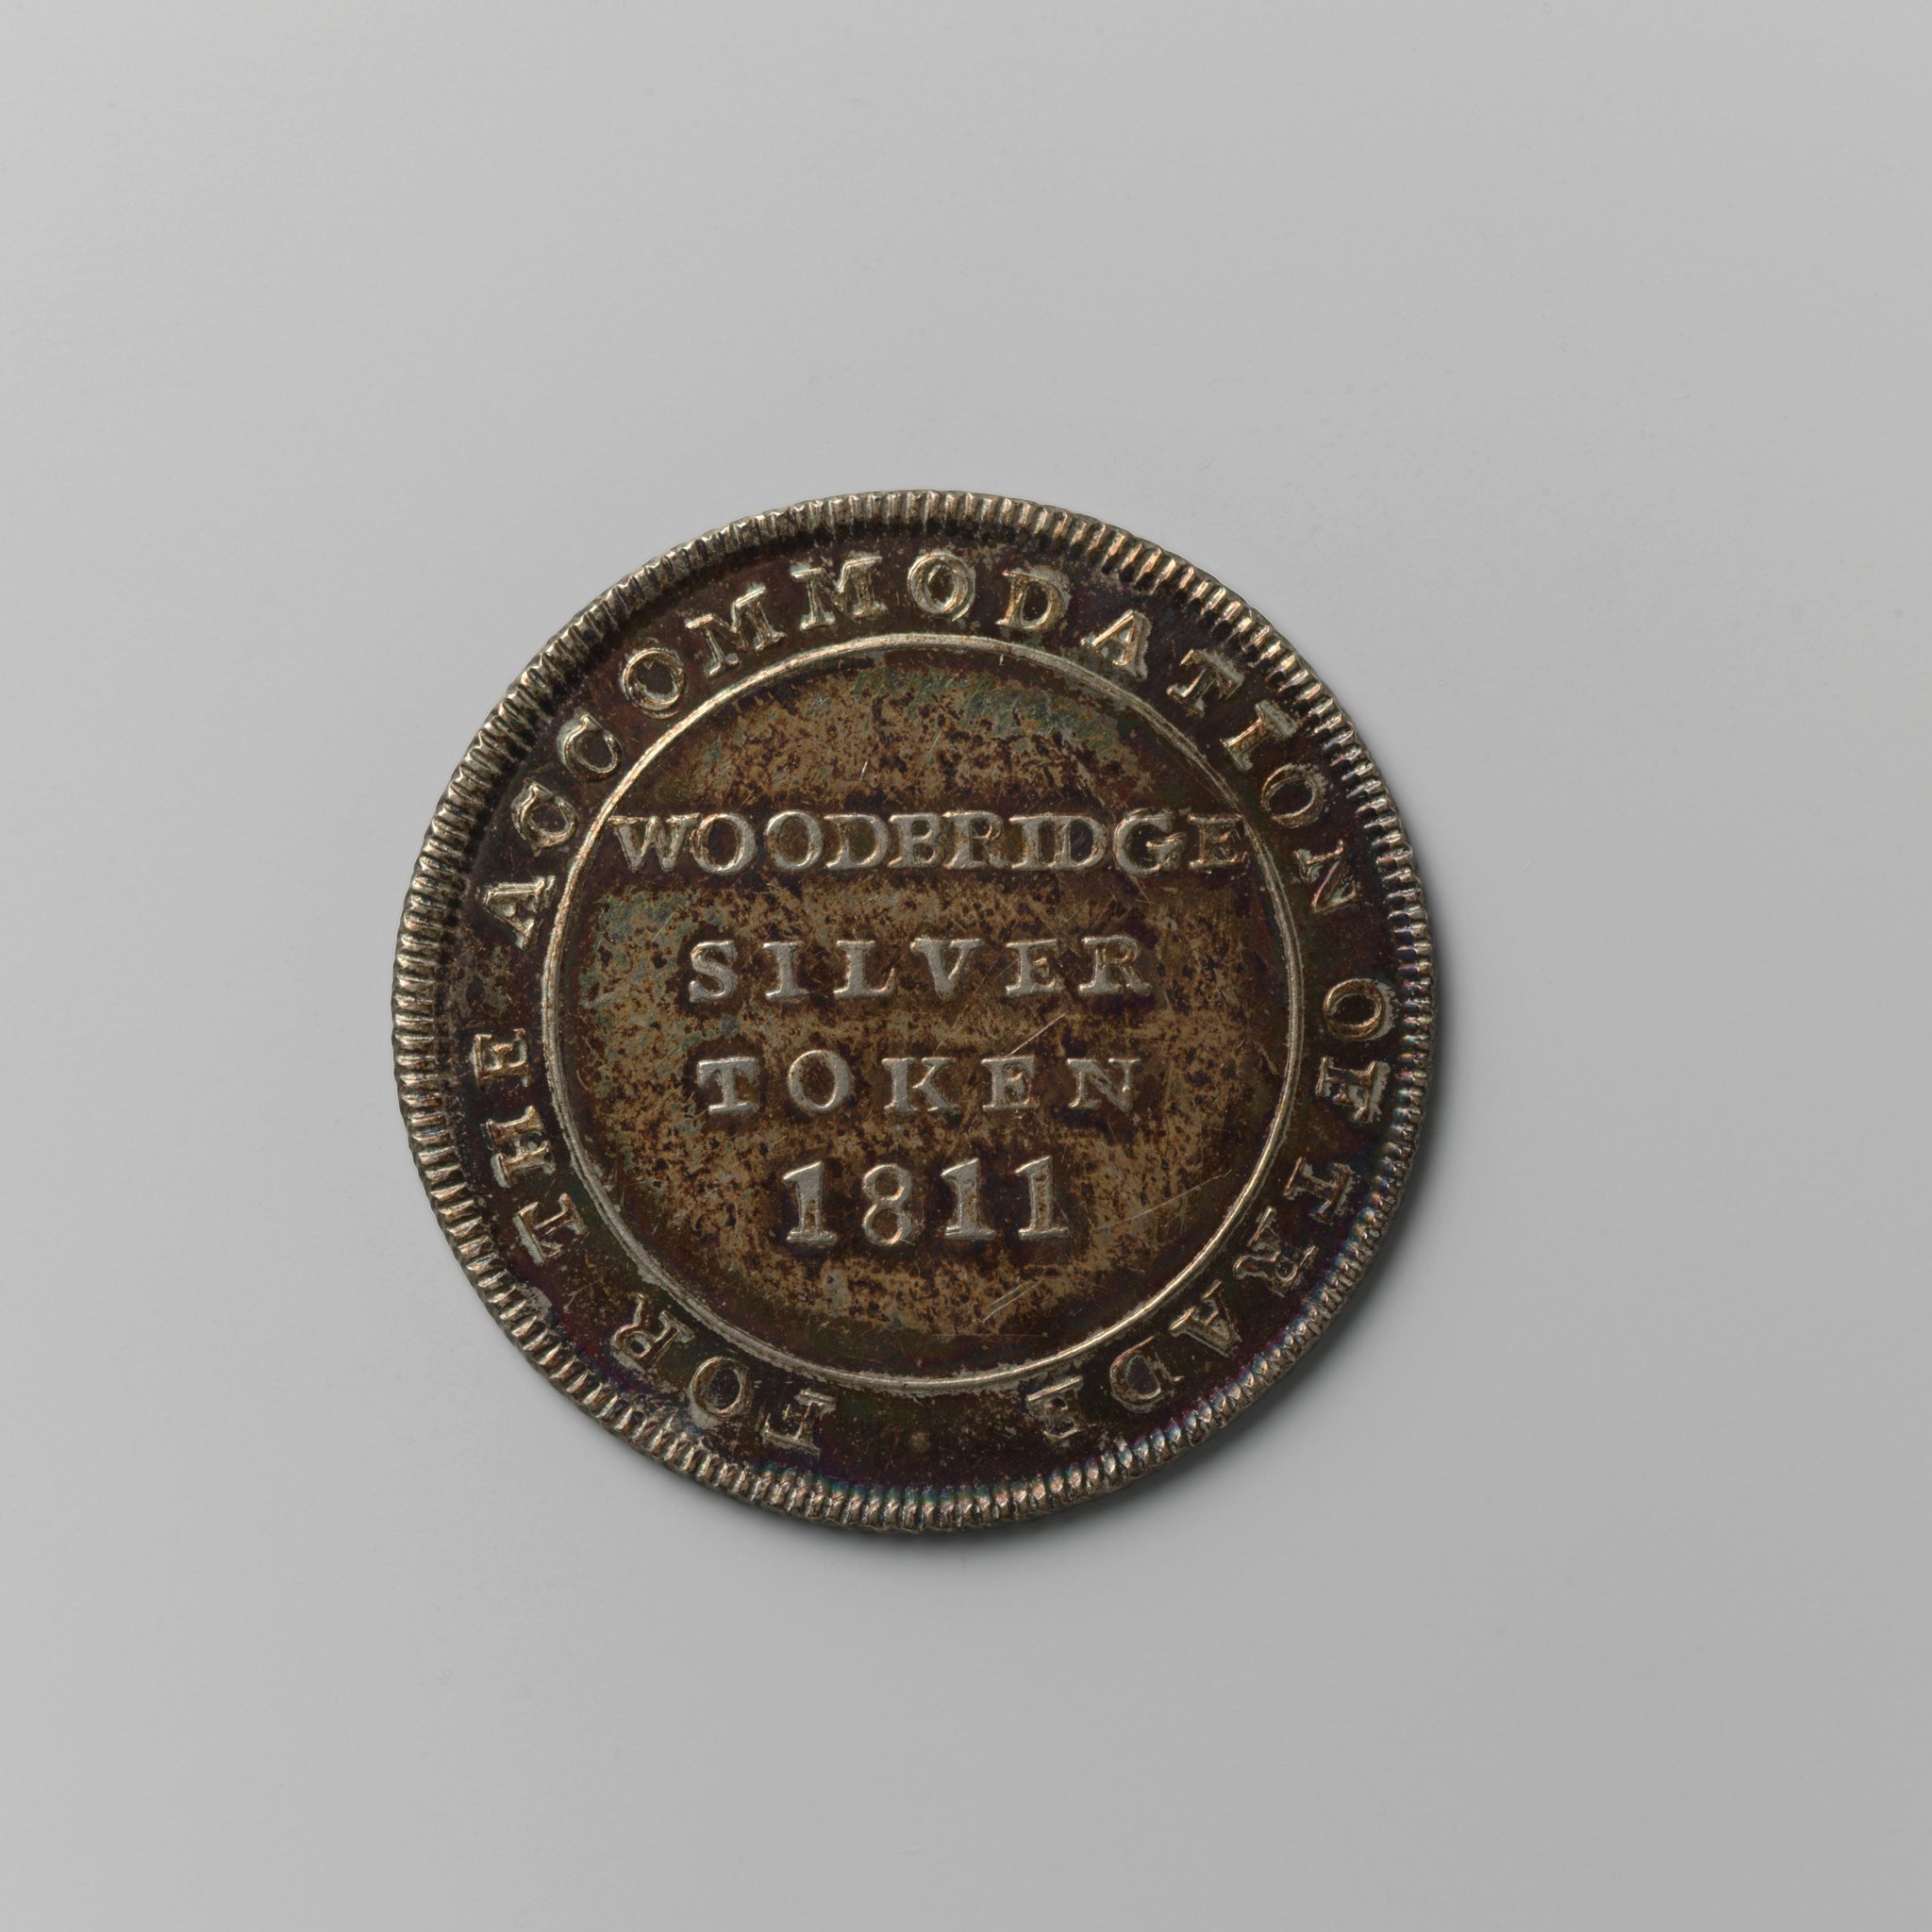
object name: monetary token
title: betaalpenning (token) voor een shilling uit Woodbridge, Engeland, 1811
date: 1811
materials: silver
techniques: striking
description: Zilveren particuliere munt. Voorzijde: drie-regerlig opschrift. Daaronder jaartal. Keerzijde: vier-regelig opschrift, waarin waarde-aanduiding. Kabelrand.